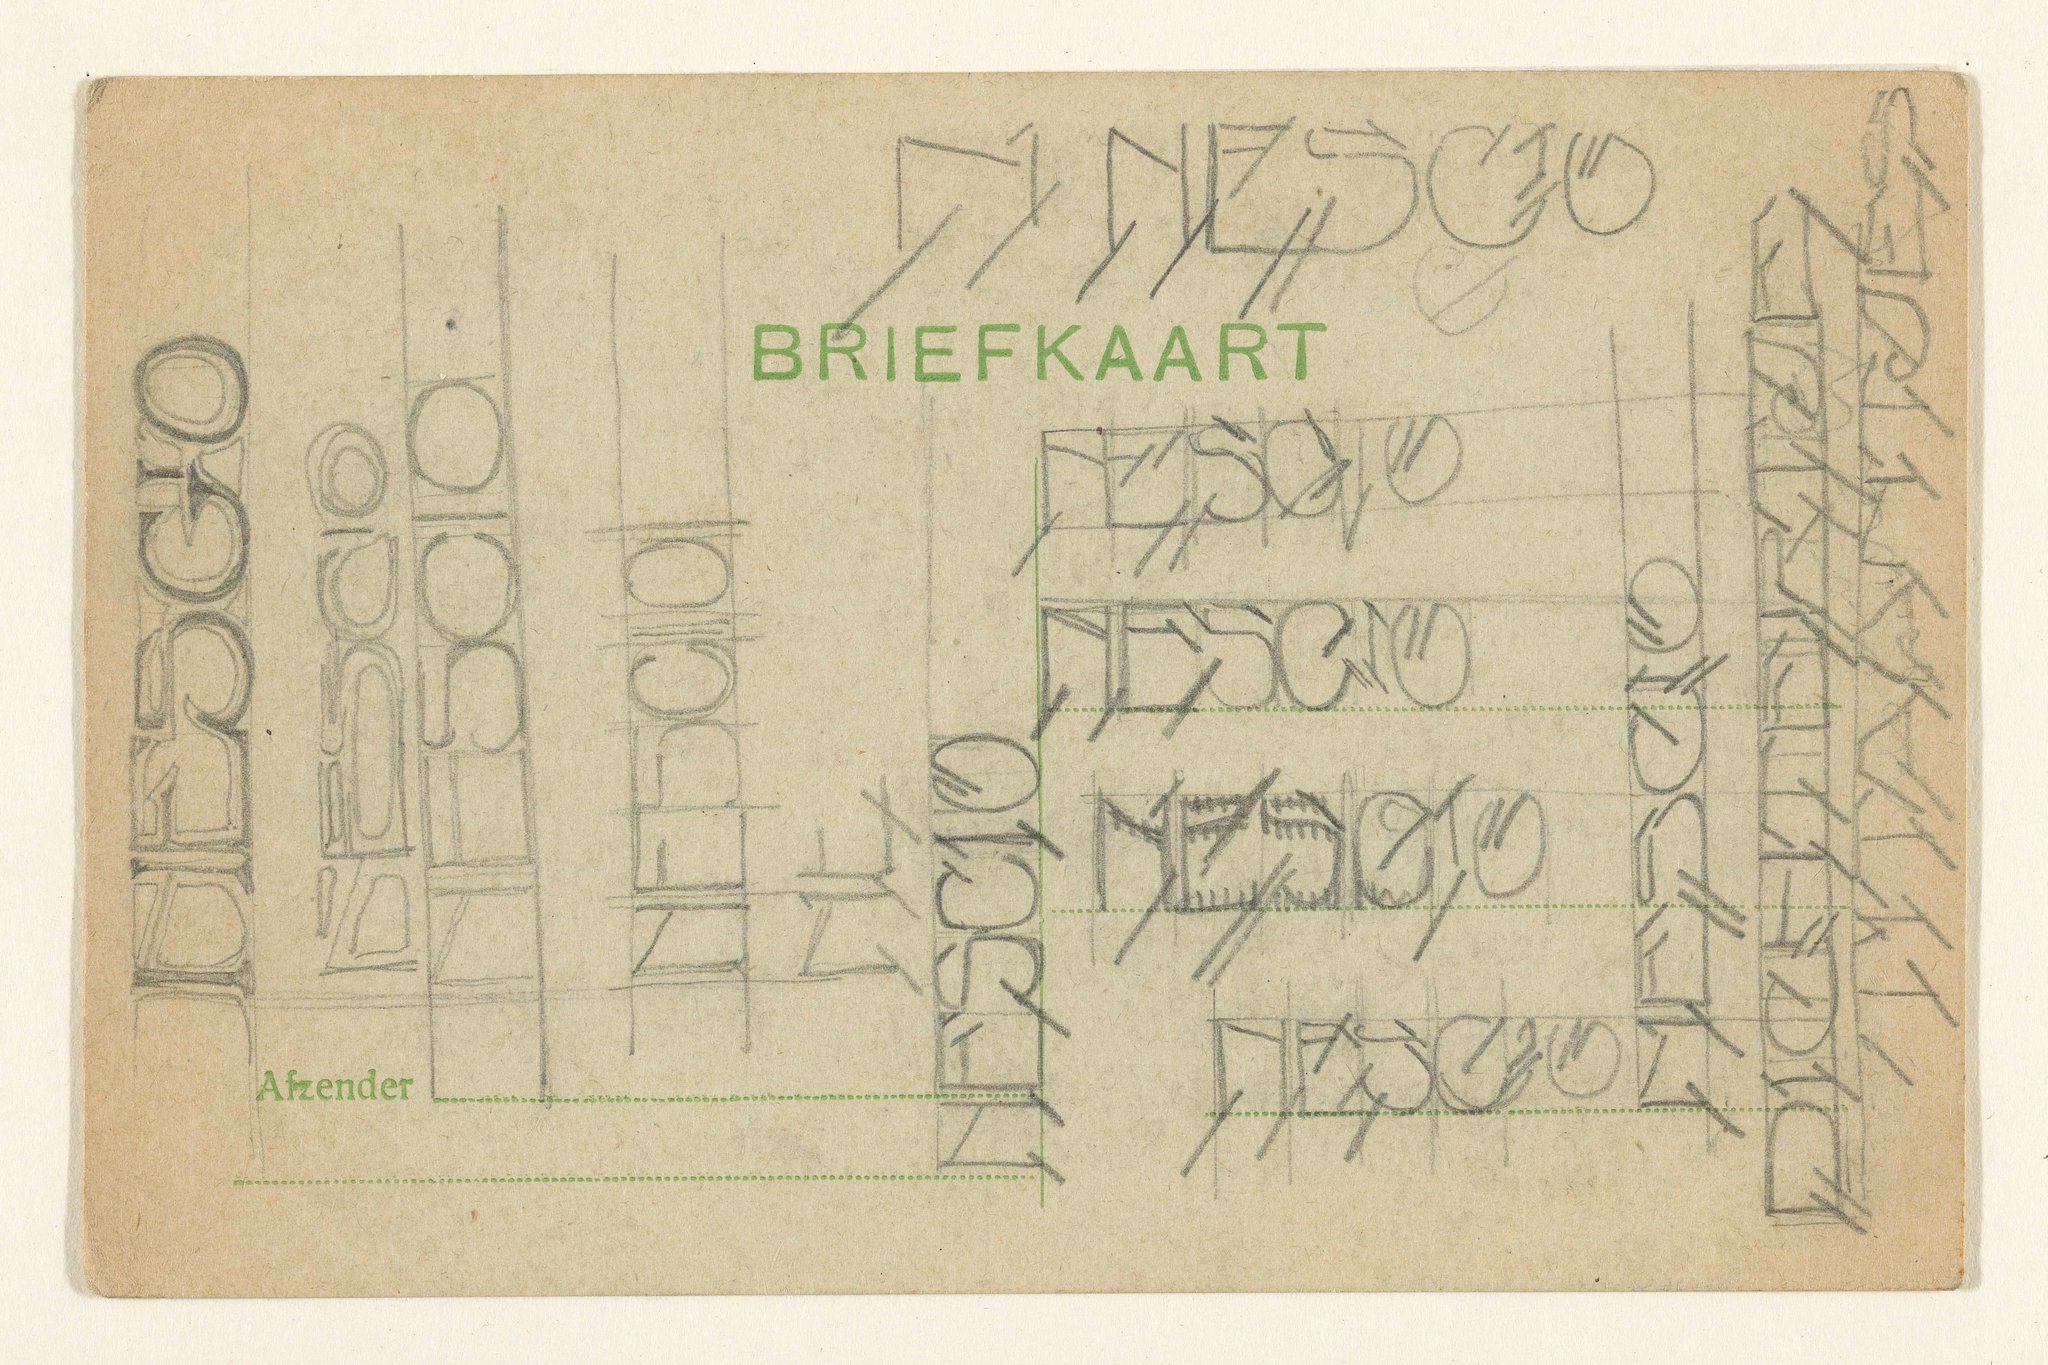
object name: drawing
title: Letterontwerp 'Nescio'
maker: reijer stolk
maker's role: draughtsman, print maker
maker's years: 1896-1945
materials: paper, pencil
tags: handwriting, writing as activity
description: Deze tekening is een ontwerp voor de titel van het bandontwerp voor: Nescio. Dichtertje, de uitvreter en titaantjes. Haarlem: Johannes Henricus de Bois, 1918.